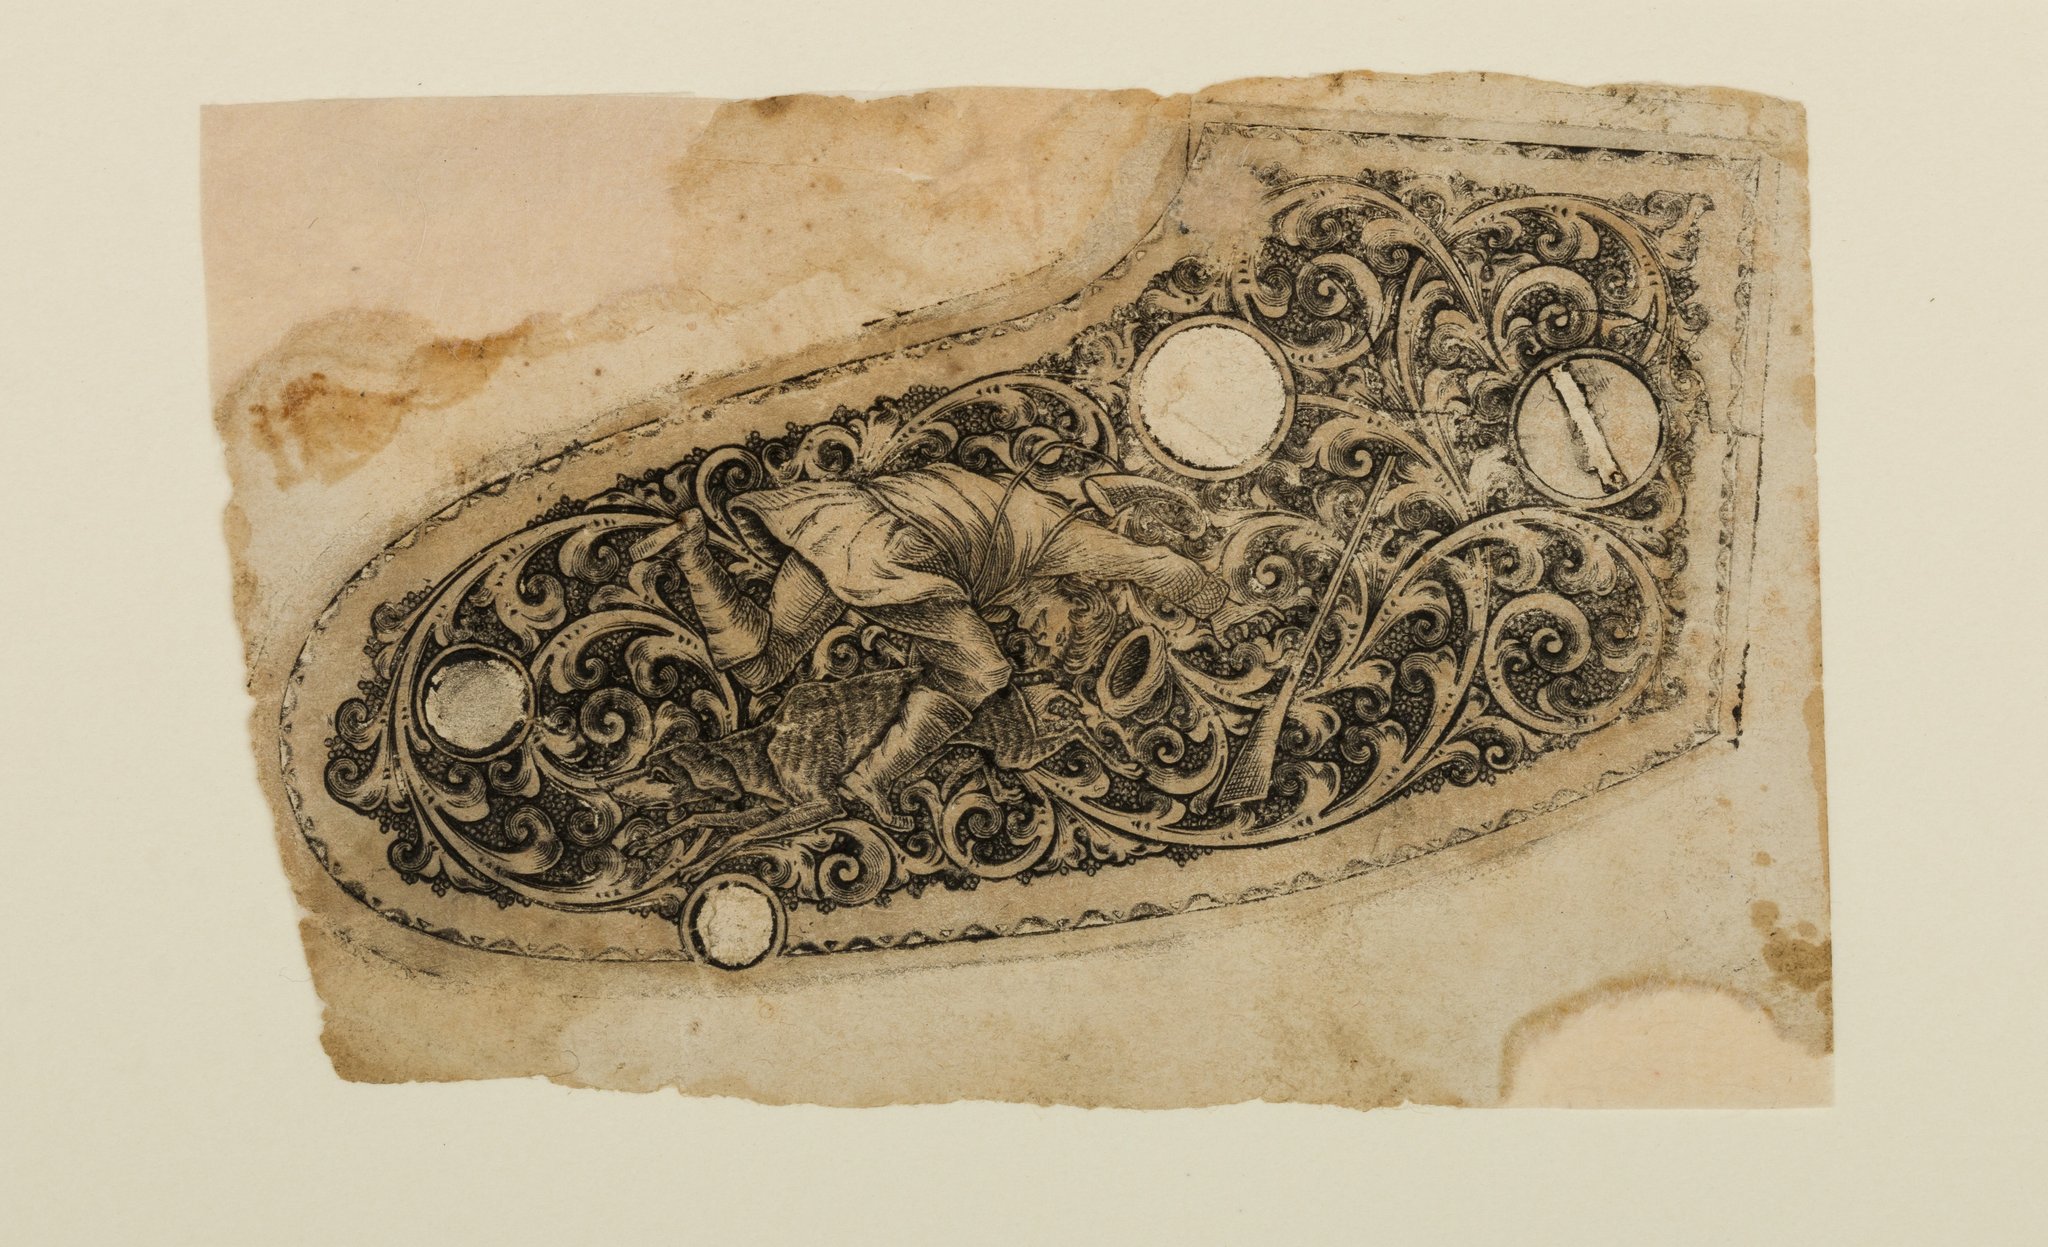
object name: inked impression of engraved firearm ornament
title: Inked Impression (or "Pull") of Engraved Firearms Ornament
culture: german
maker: ernst moritz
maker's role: decorator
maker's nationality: german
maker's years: 1801-1900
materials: ink, paper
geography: germany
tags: ornament